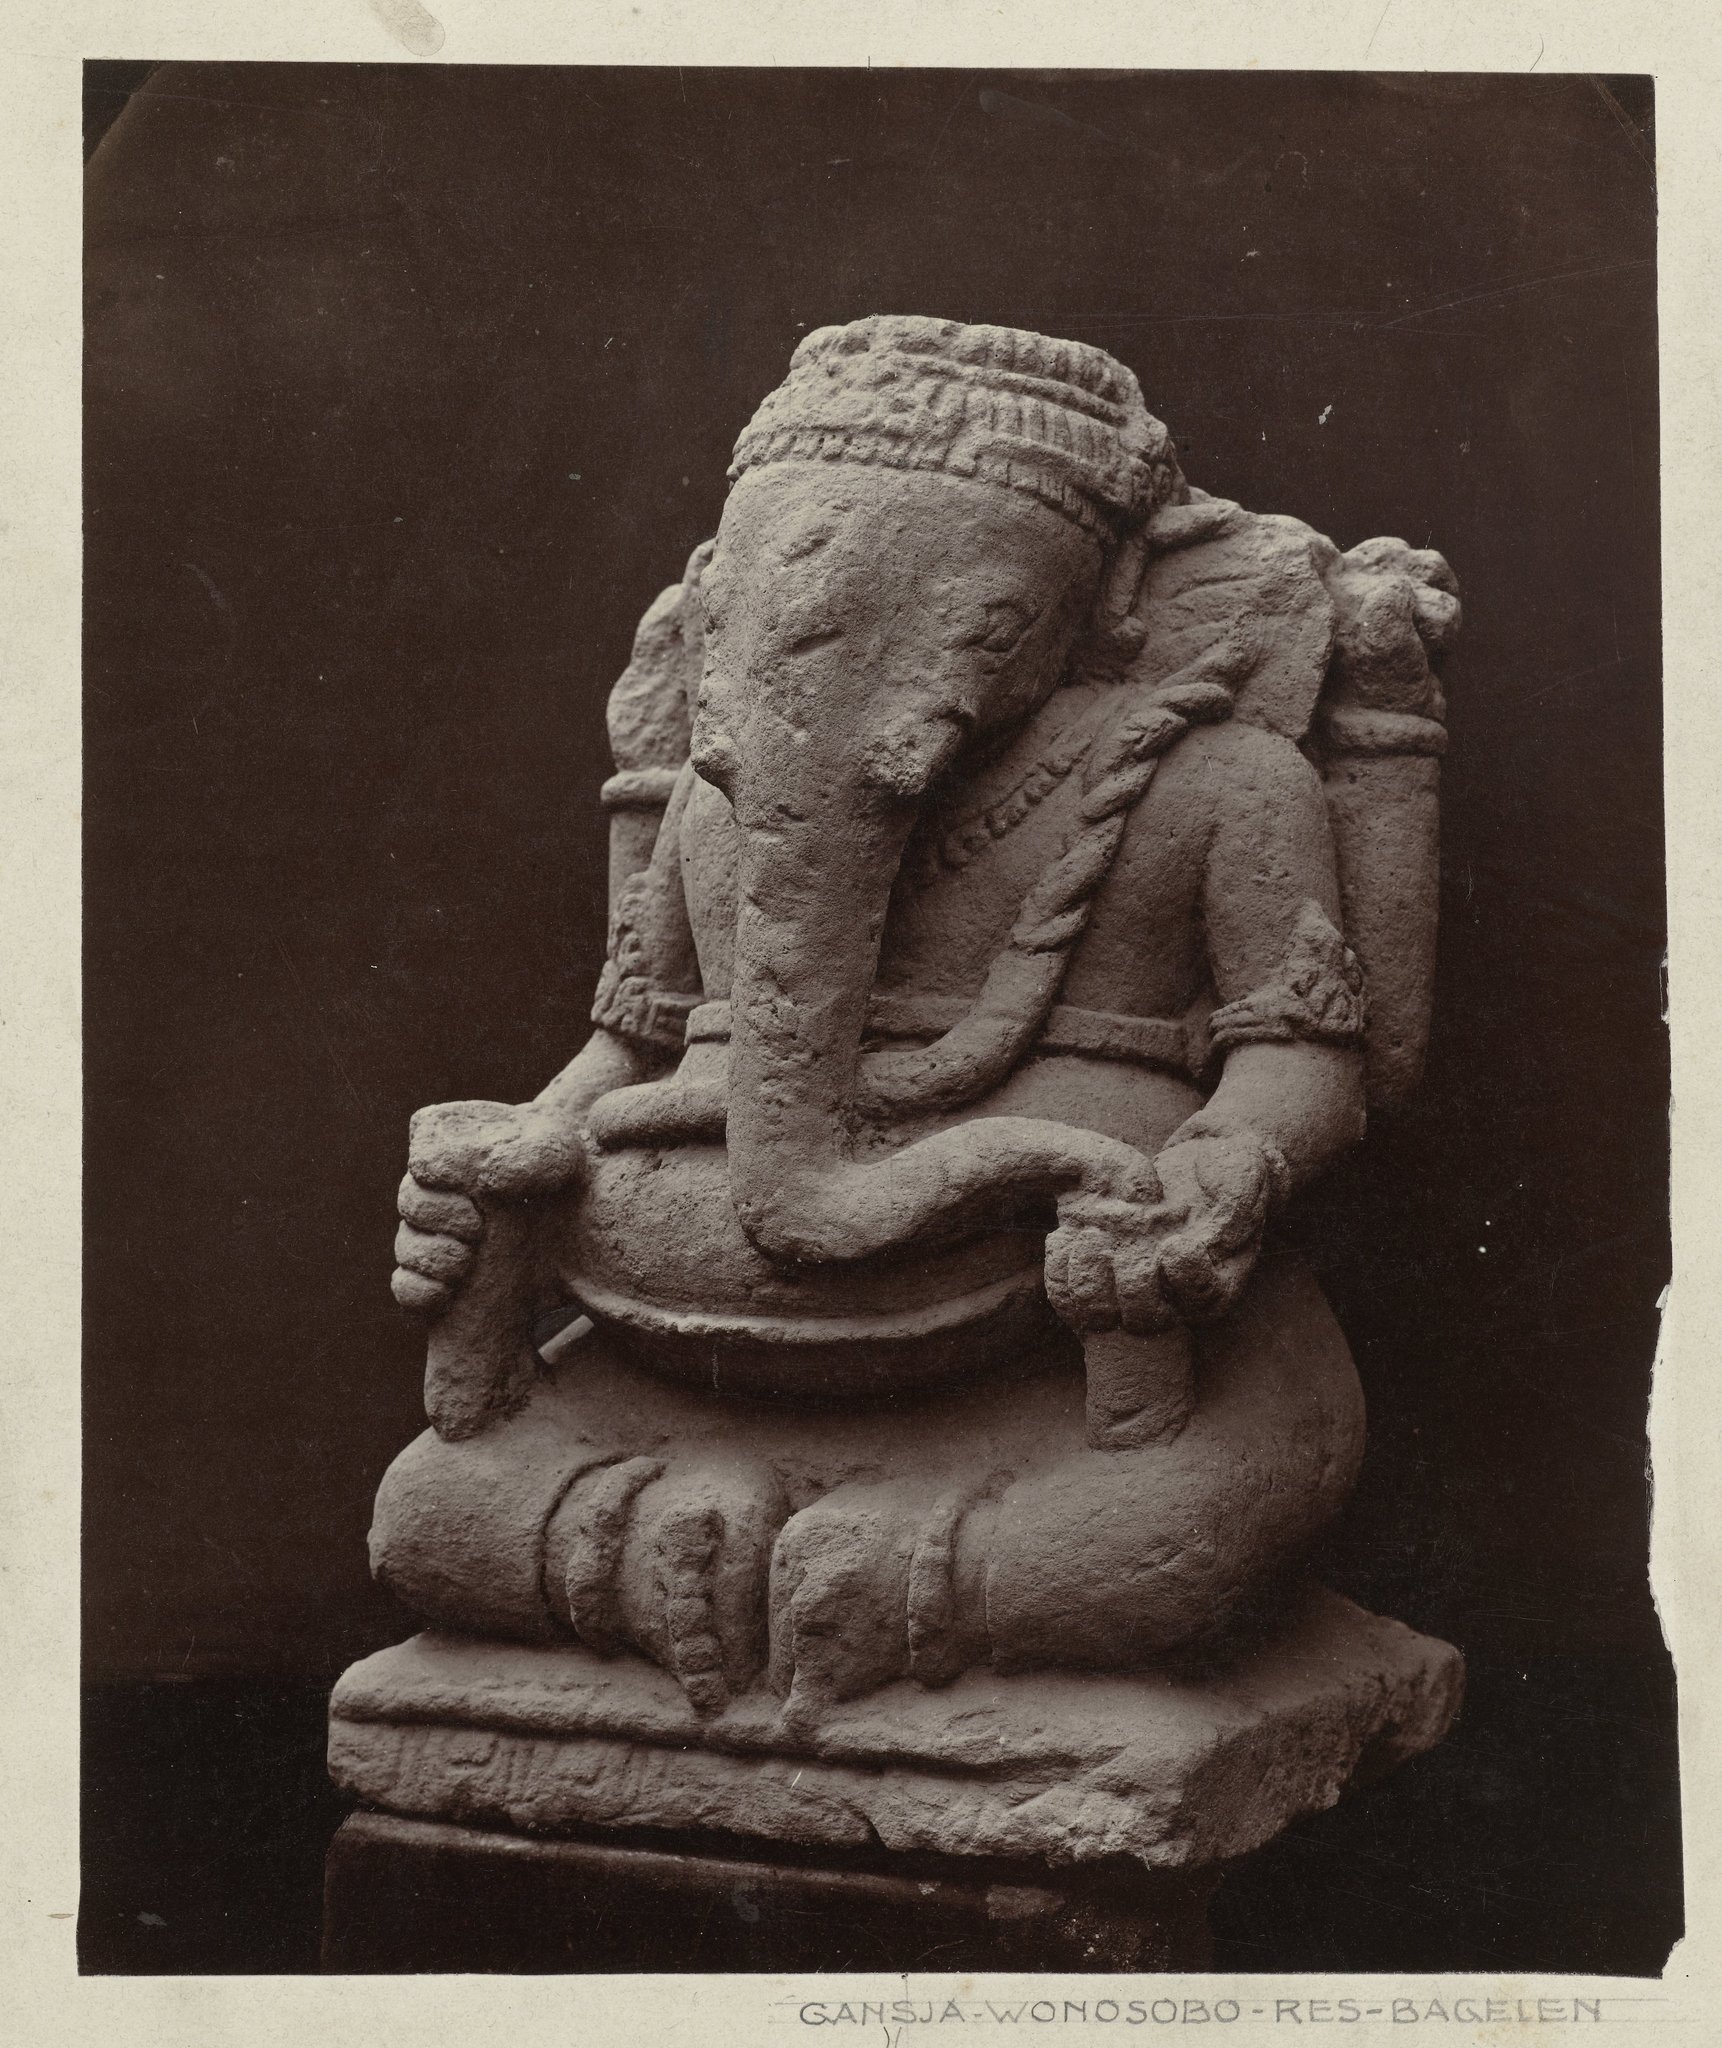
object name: photograph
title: Beeld van een vierarmige Ganesha in de tuin van de assistent-resident van Wonosobo.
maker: isidore kinsbergen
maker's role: fotograaf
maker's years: 1821-1905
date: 1808-1864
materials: cardboard, paper, photographic support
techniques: albumen print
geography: java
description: Four-armed Ganesha axhibited in the garden of the asisstent-resident of Wonosobo (provenance Diëng Plateau). Wonosobo, Wonosobo district, Central Java province, 10th-11th century